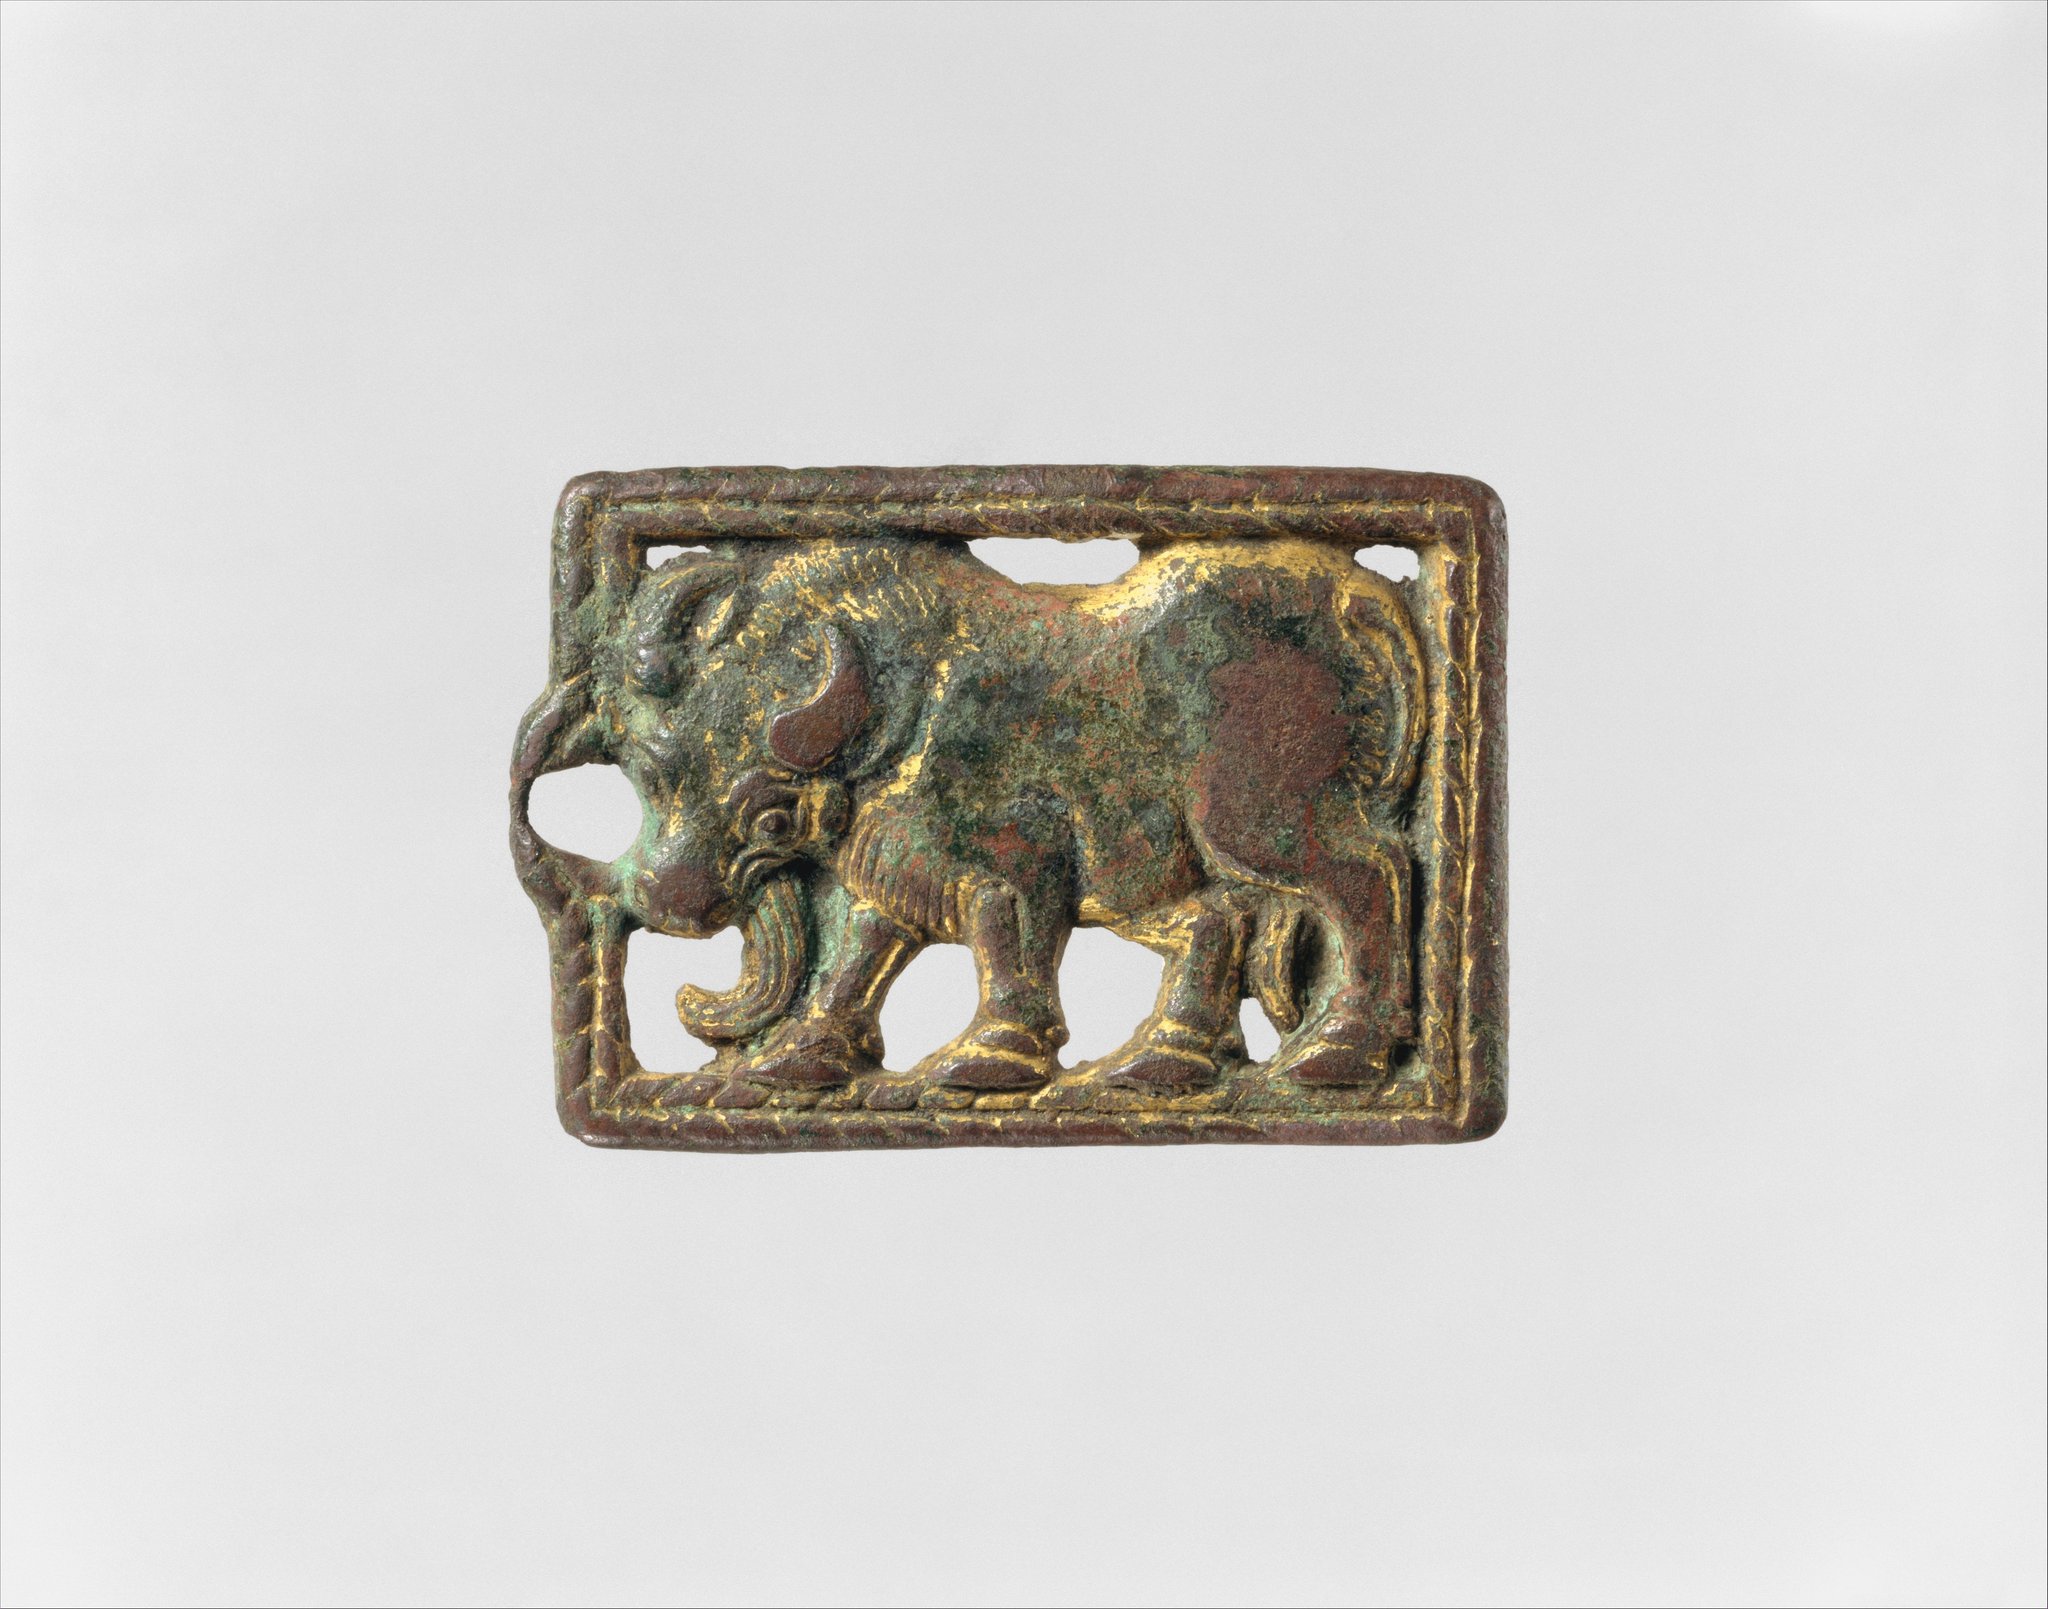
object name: belt buckle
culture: north chinese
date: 300-101 BCE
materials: bronze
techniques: gilding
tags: ox